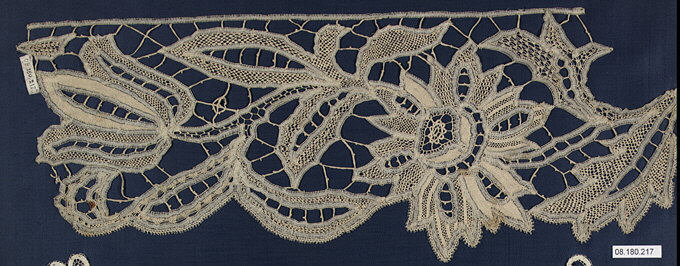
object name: fragment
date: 1801-1900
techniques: lace